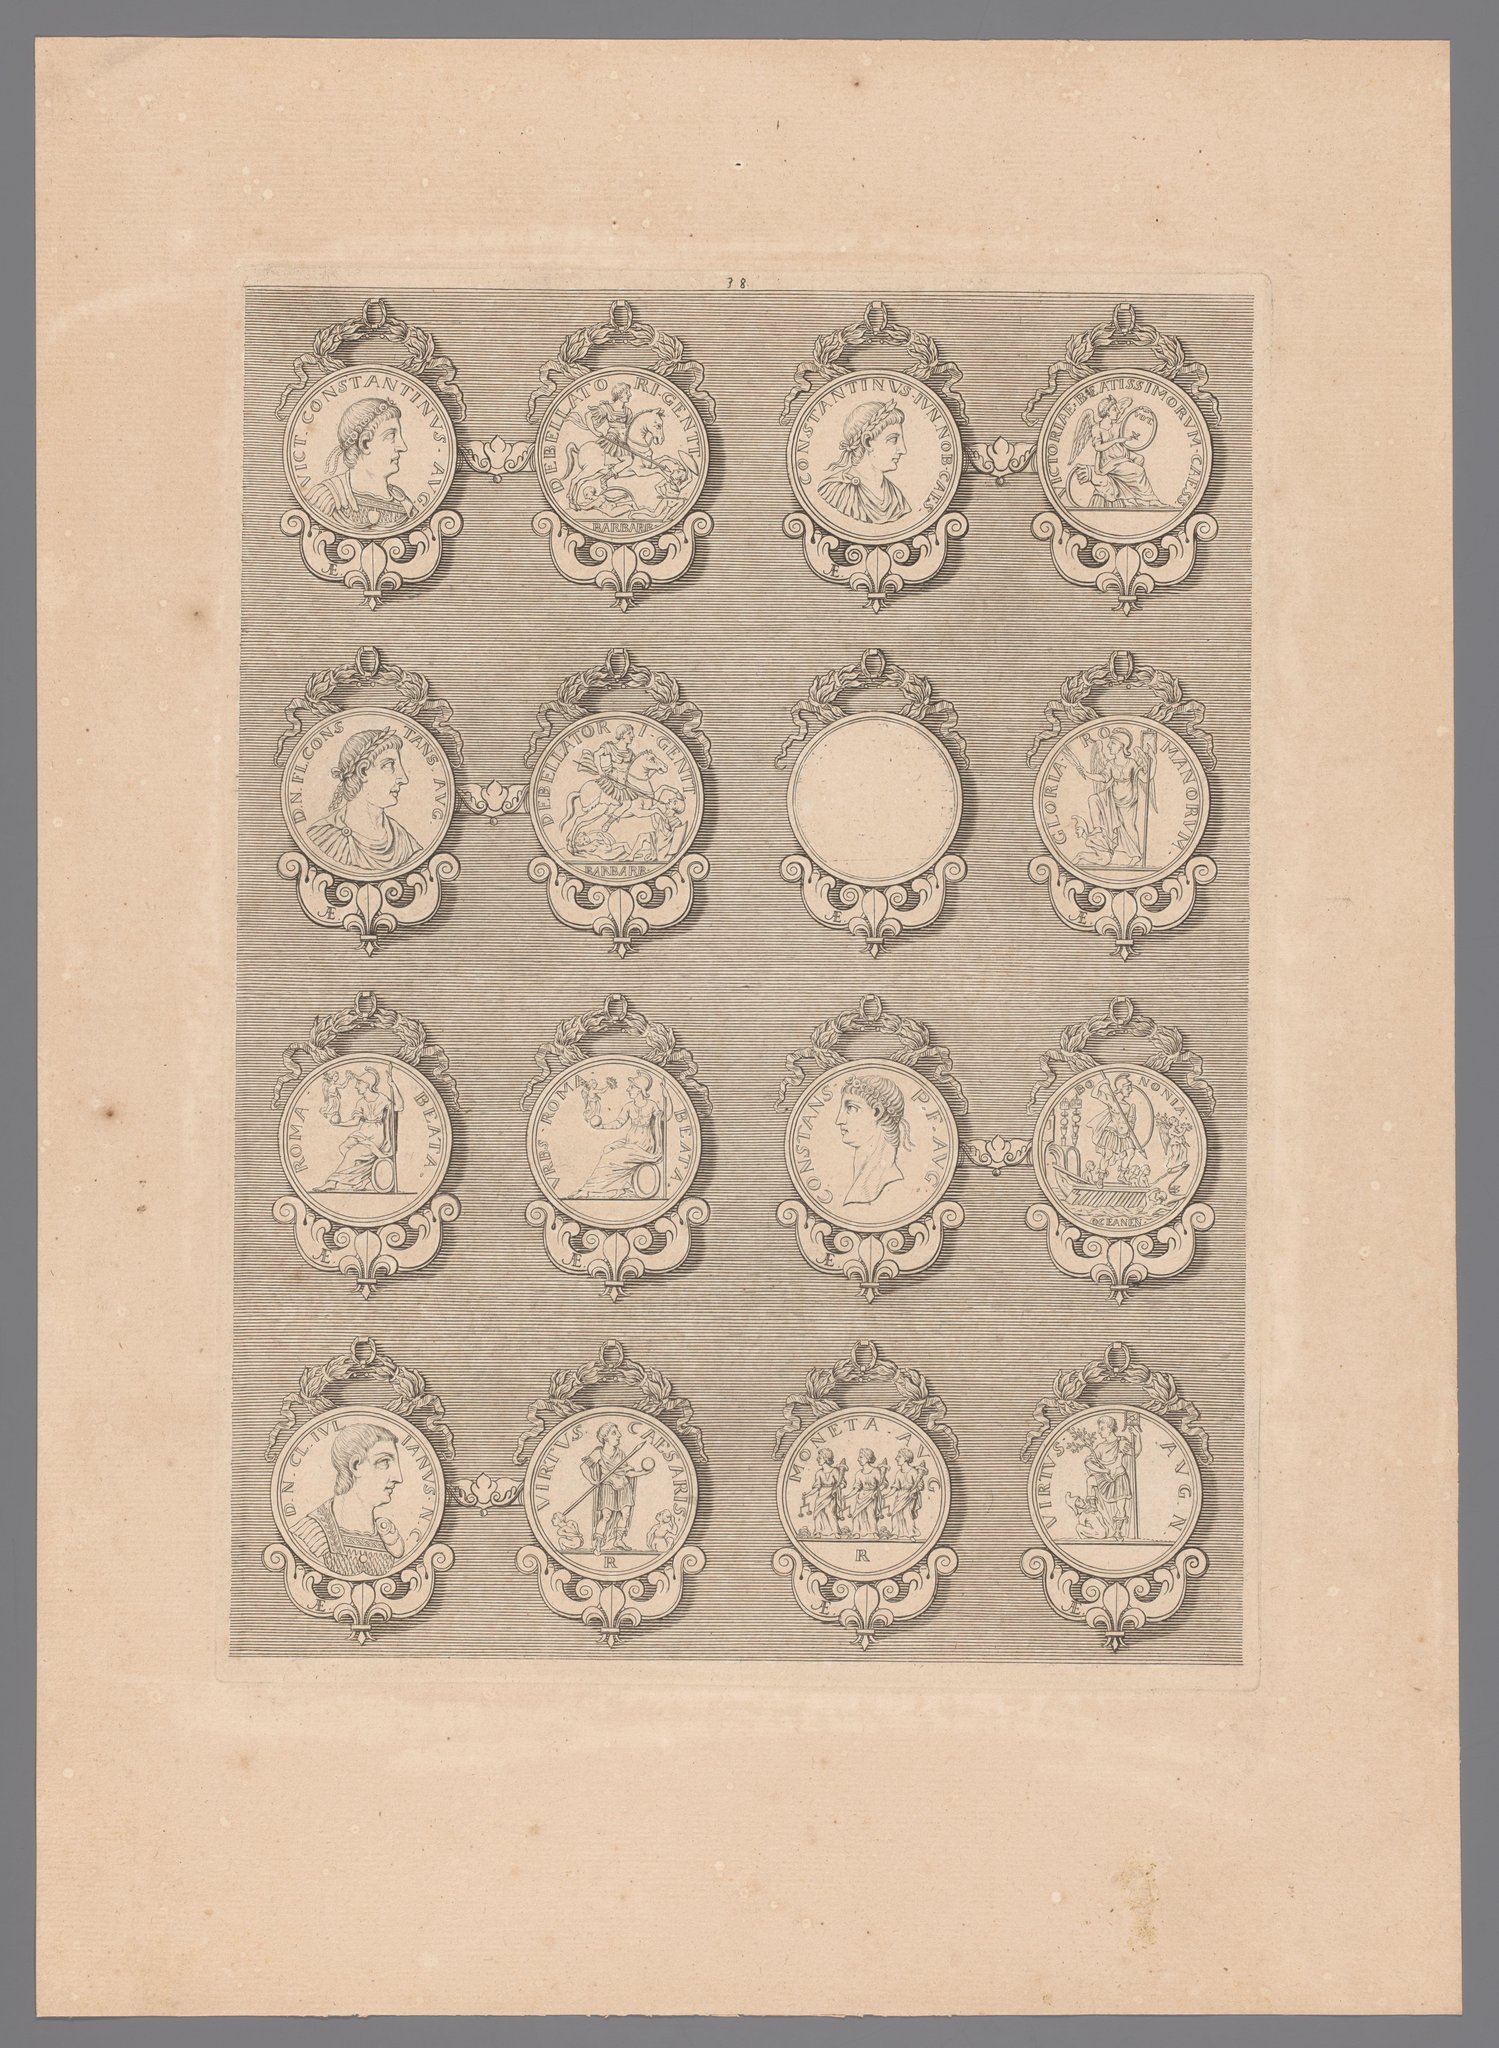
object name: print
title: Zestien penningen met versierde lijsten, waarvan één blanco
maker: simon de la boissière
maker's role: print maker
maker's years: 1637-1682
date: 1647-1682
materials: paper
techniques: etching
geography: france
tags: medal (considered as a piece of sculpture, regardless of its specific function)